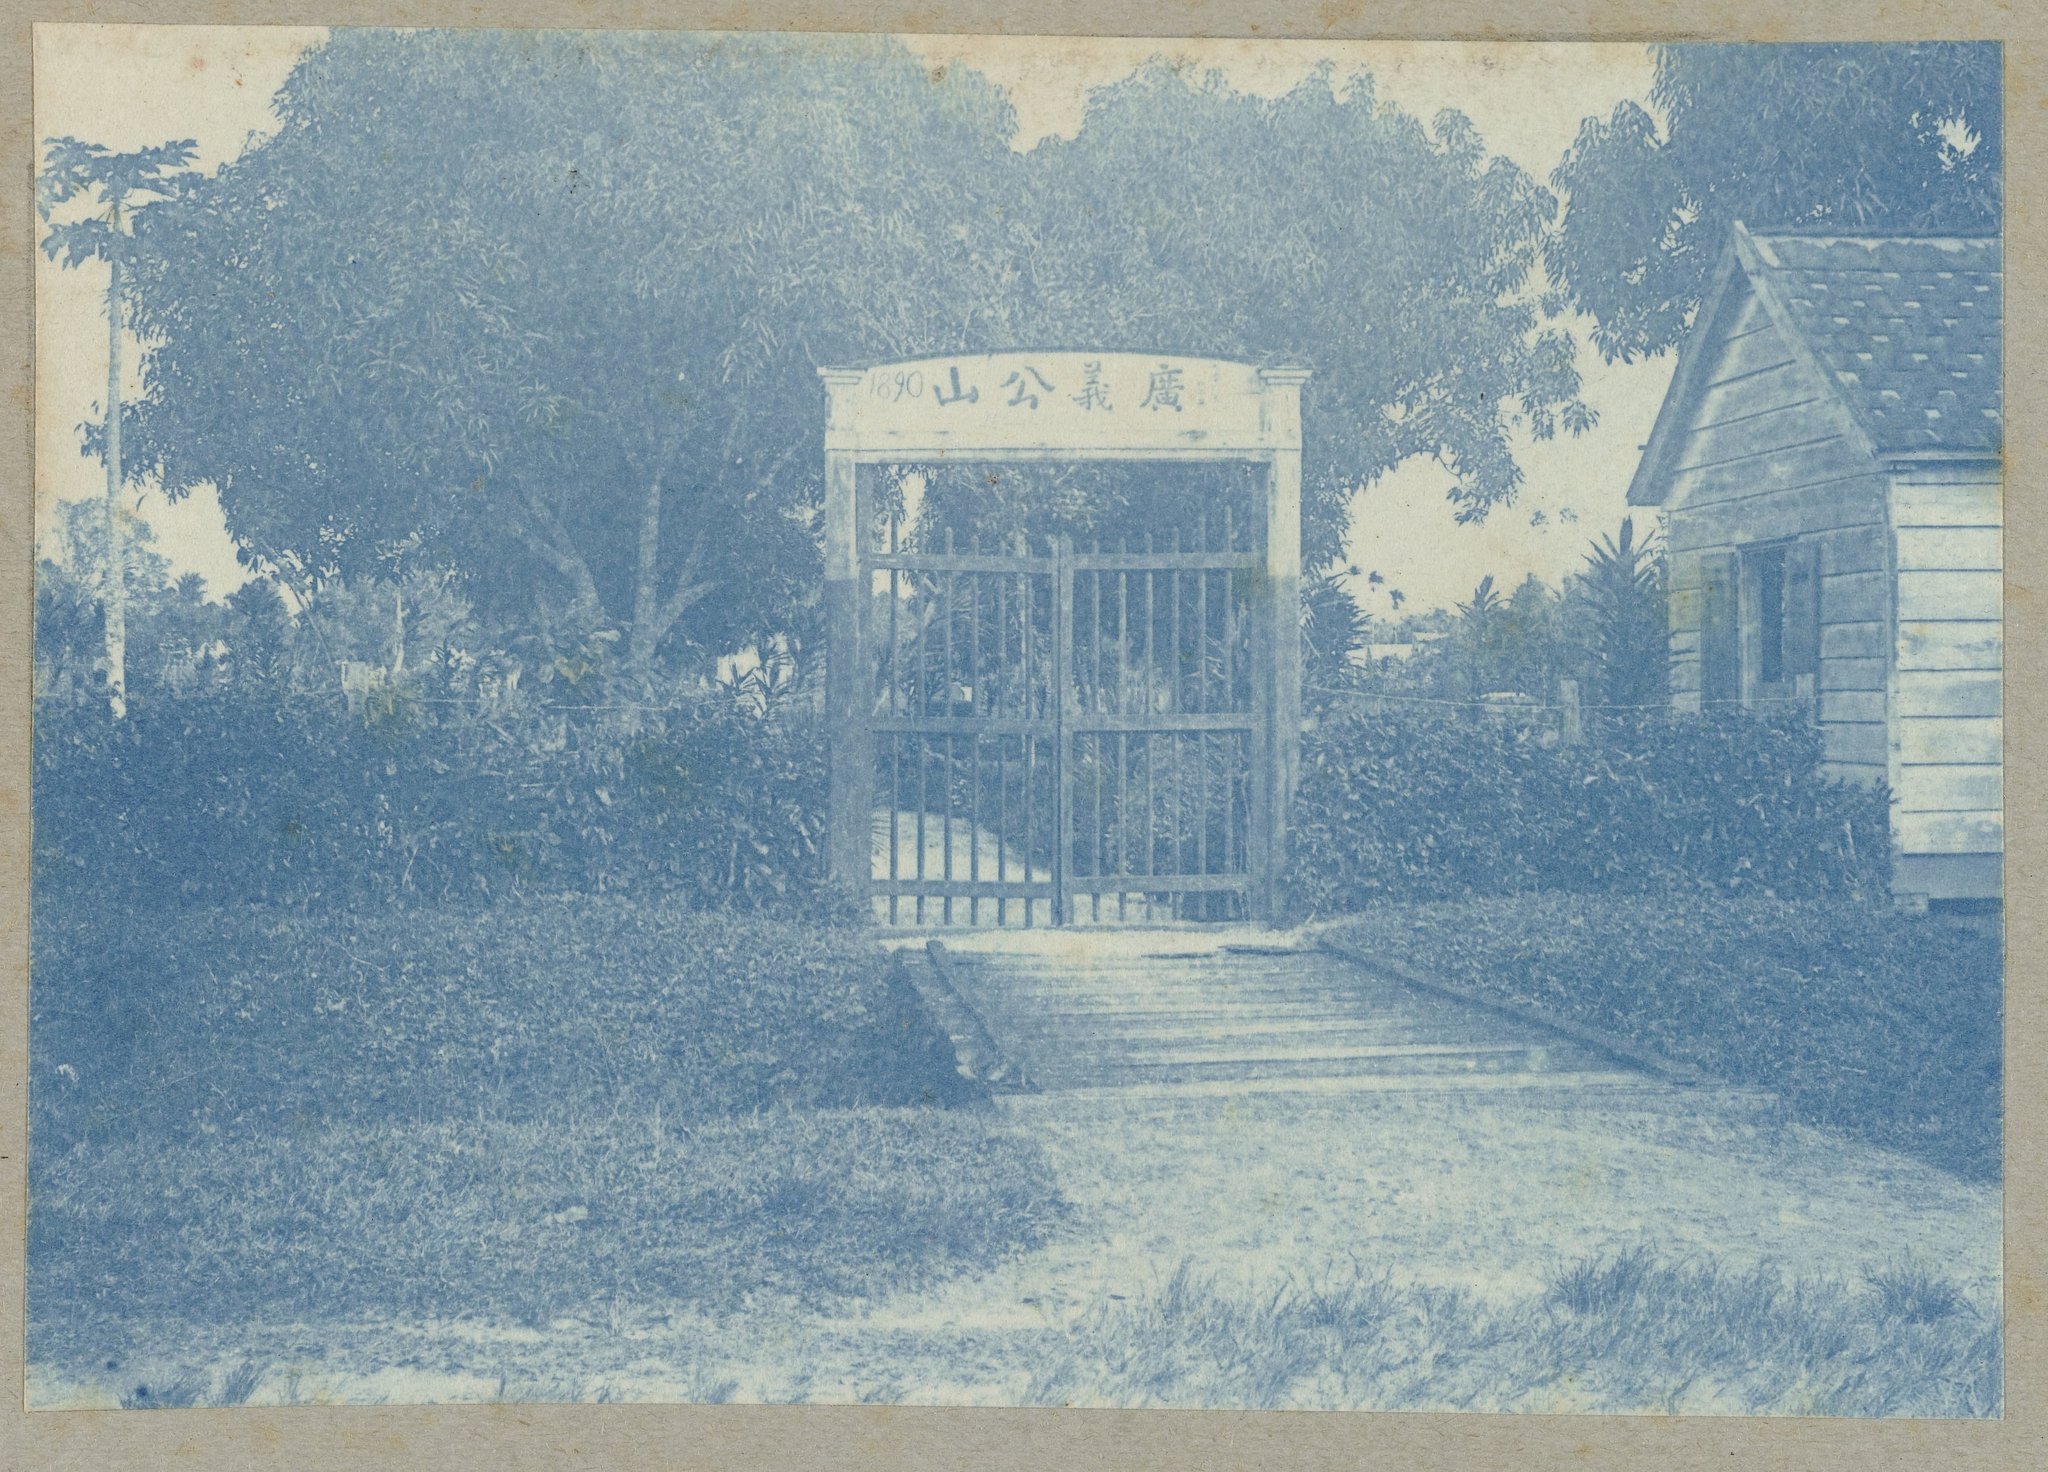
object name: photograph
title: Ingang Wanicastraat van Chineesch kerkhof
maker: hendrik doijer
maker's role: engineer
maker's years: 1863-1925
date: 1903-1910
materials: photographic support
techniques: cyanotype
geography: suriname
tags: suriname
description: Toegangshek naar het Chinese kerkhof aan de Wanicastraat te Paramaribo, boven het hek een bord met Chinese tekens, het jaartal 1890 en de naam Willemsrust of Willems Rust. Onderdeel van het fotoalbum Souvenir de Voyage (deel 2), over het leven van de familie Doijer in en rond de plantage Ma Retraite in Suriname in de jaren 1903-1910.